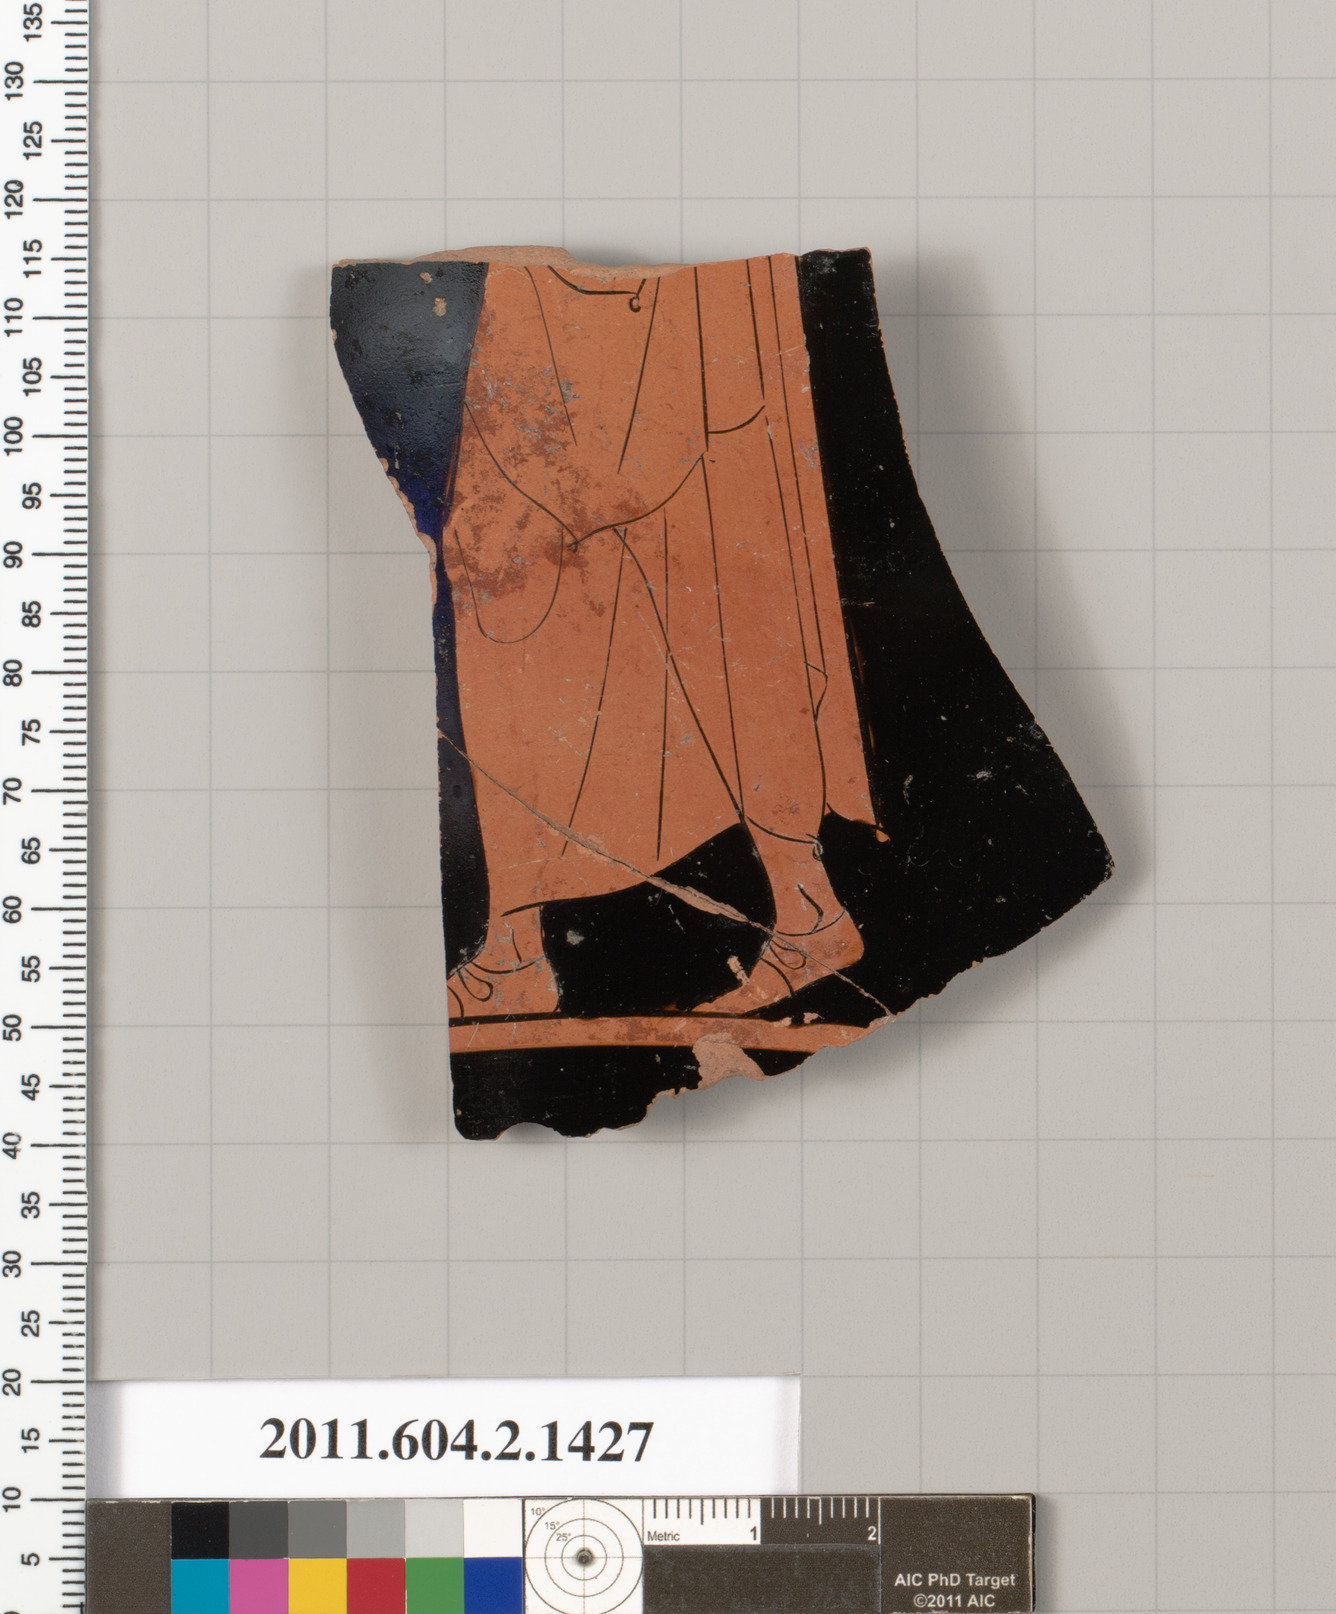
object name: skyphos fragment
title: Terracotta fragment of a skyphos (deep drinking cup)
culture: greek, attic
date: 475-451 BCE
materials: terracotta